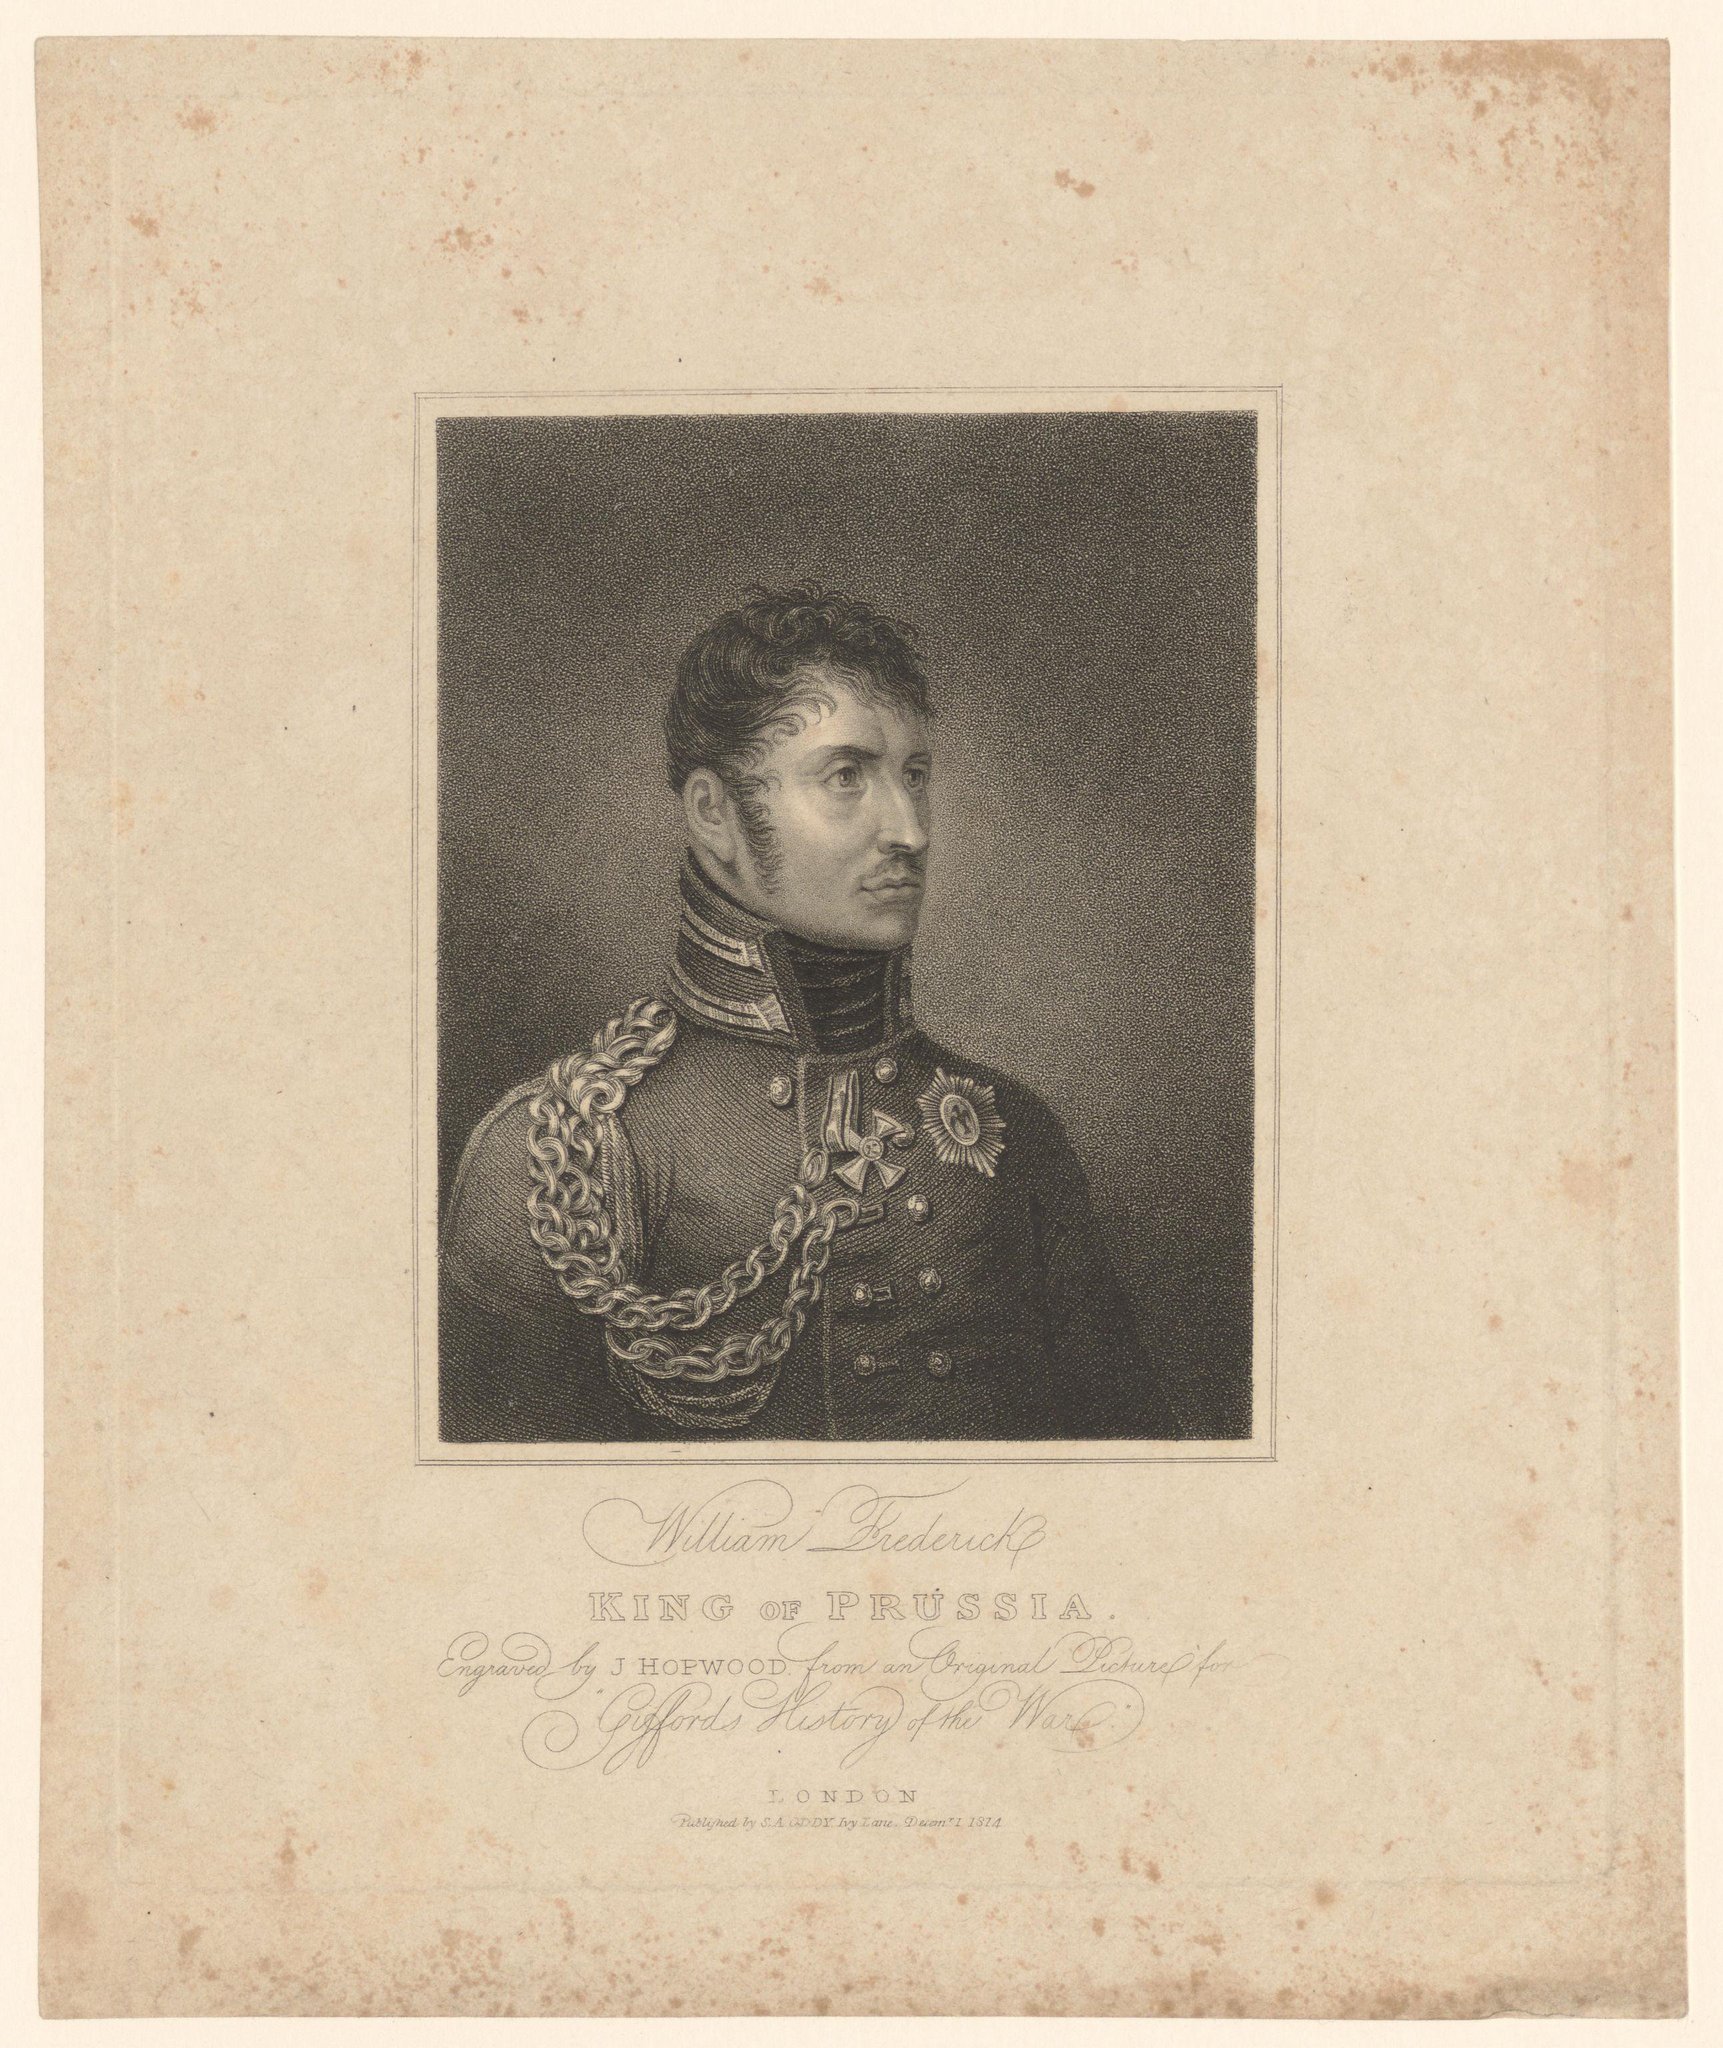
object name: book illustration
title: Portret van Frederik Willem III van Pruisen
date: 1812-1814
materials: paper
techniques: etching, engraving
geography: london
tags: berlin, frederik willem iii koning van pruisen, historical persons, king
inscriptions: collector's mark: Lugt 2228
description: Prent ook gebruikt in: Gifford, C.H. History of the Wars occasioned by the French Revolution (...). Londen: S.A. Oddy, 1814.